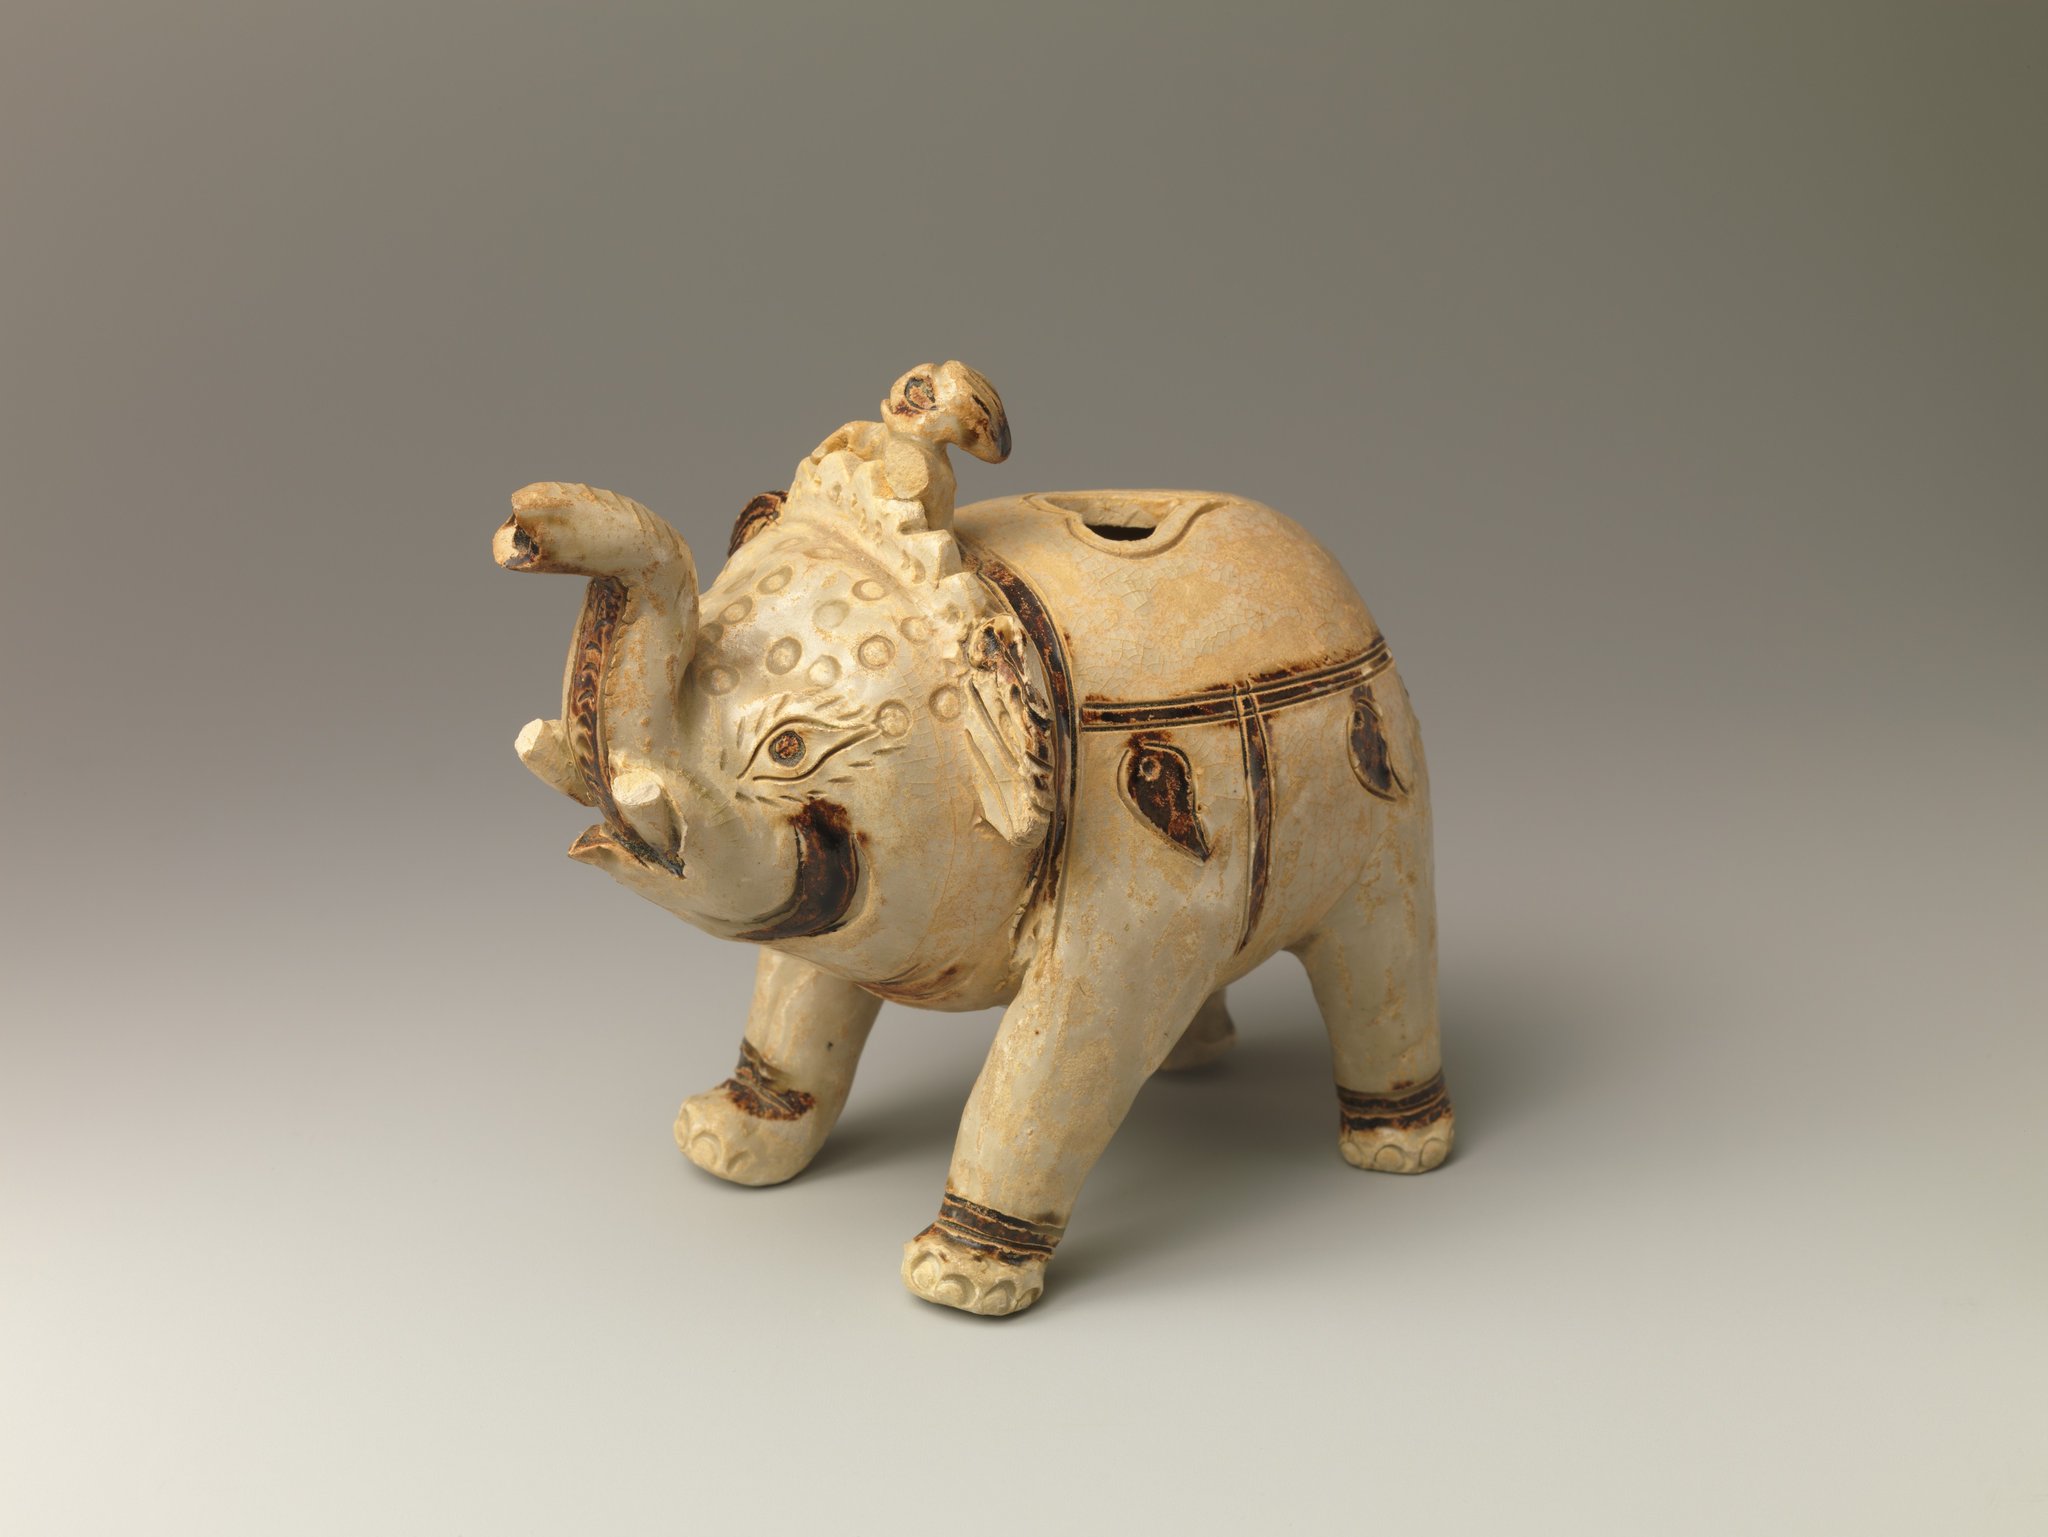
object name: ewer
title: Ewer in the Form of an Elephant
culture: vietnamese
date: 1001-1200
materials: pottery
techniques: glazing, incising, inlay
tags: elephants